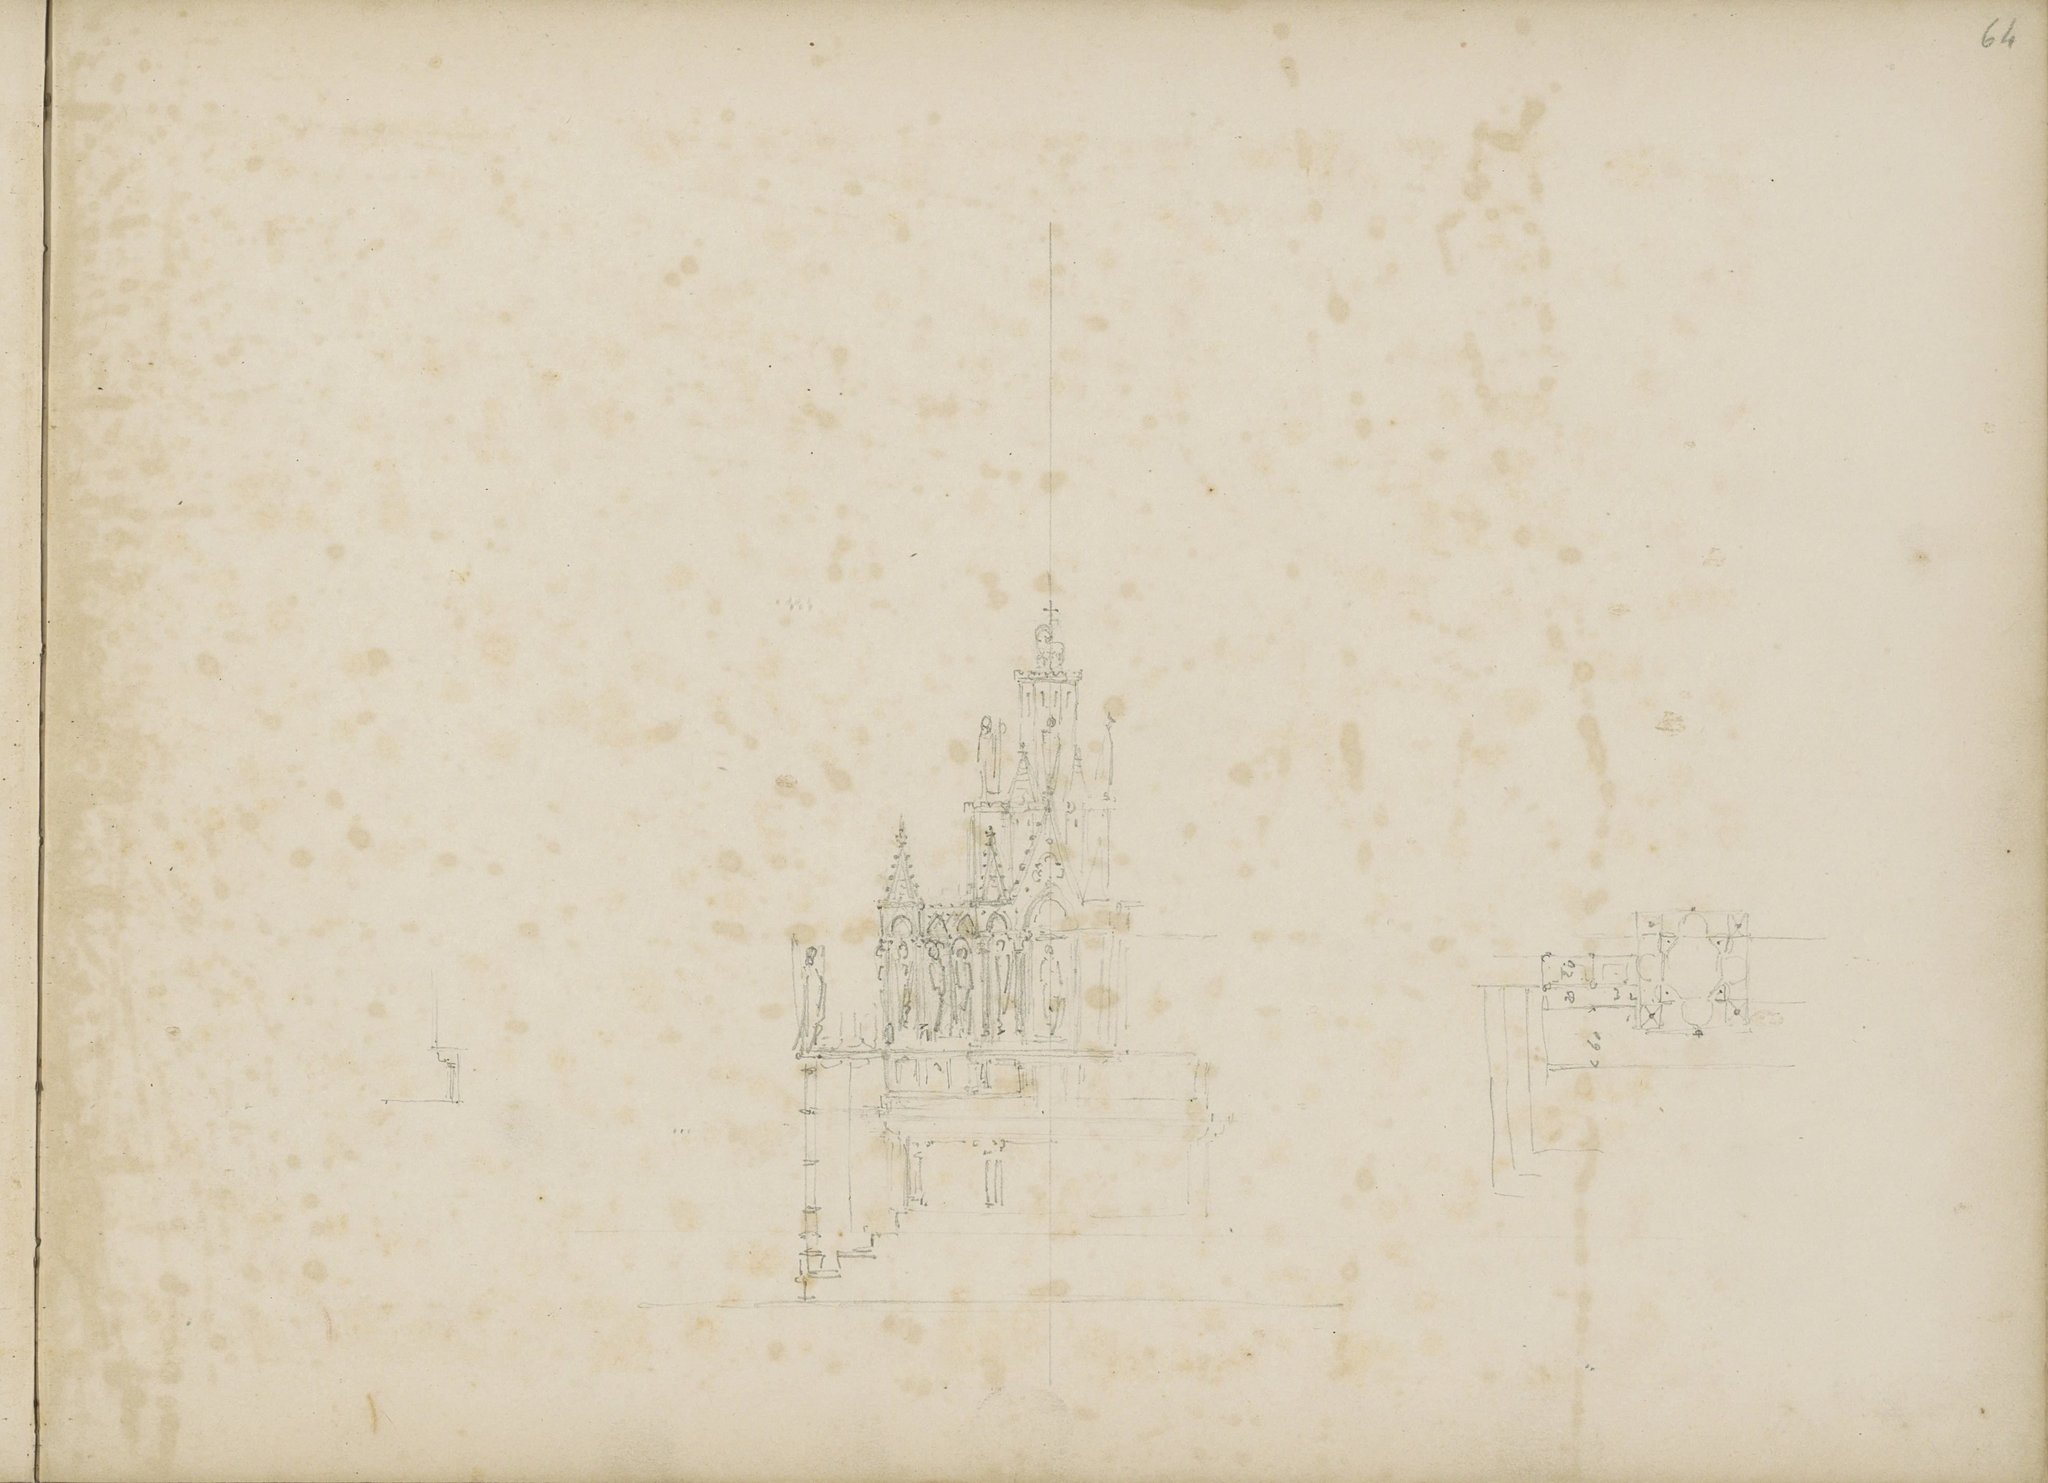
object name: sketchbook leaf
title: Altaar en plattegrond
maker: pierre joseph hubert cuypers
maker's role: draughtsman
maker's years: 1827-1921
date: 1857-1859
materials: paper, pencil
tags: plan ~ architecture, altar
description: Blad 64 recto uit een schetsboek met 77 bladen.